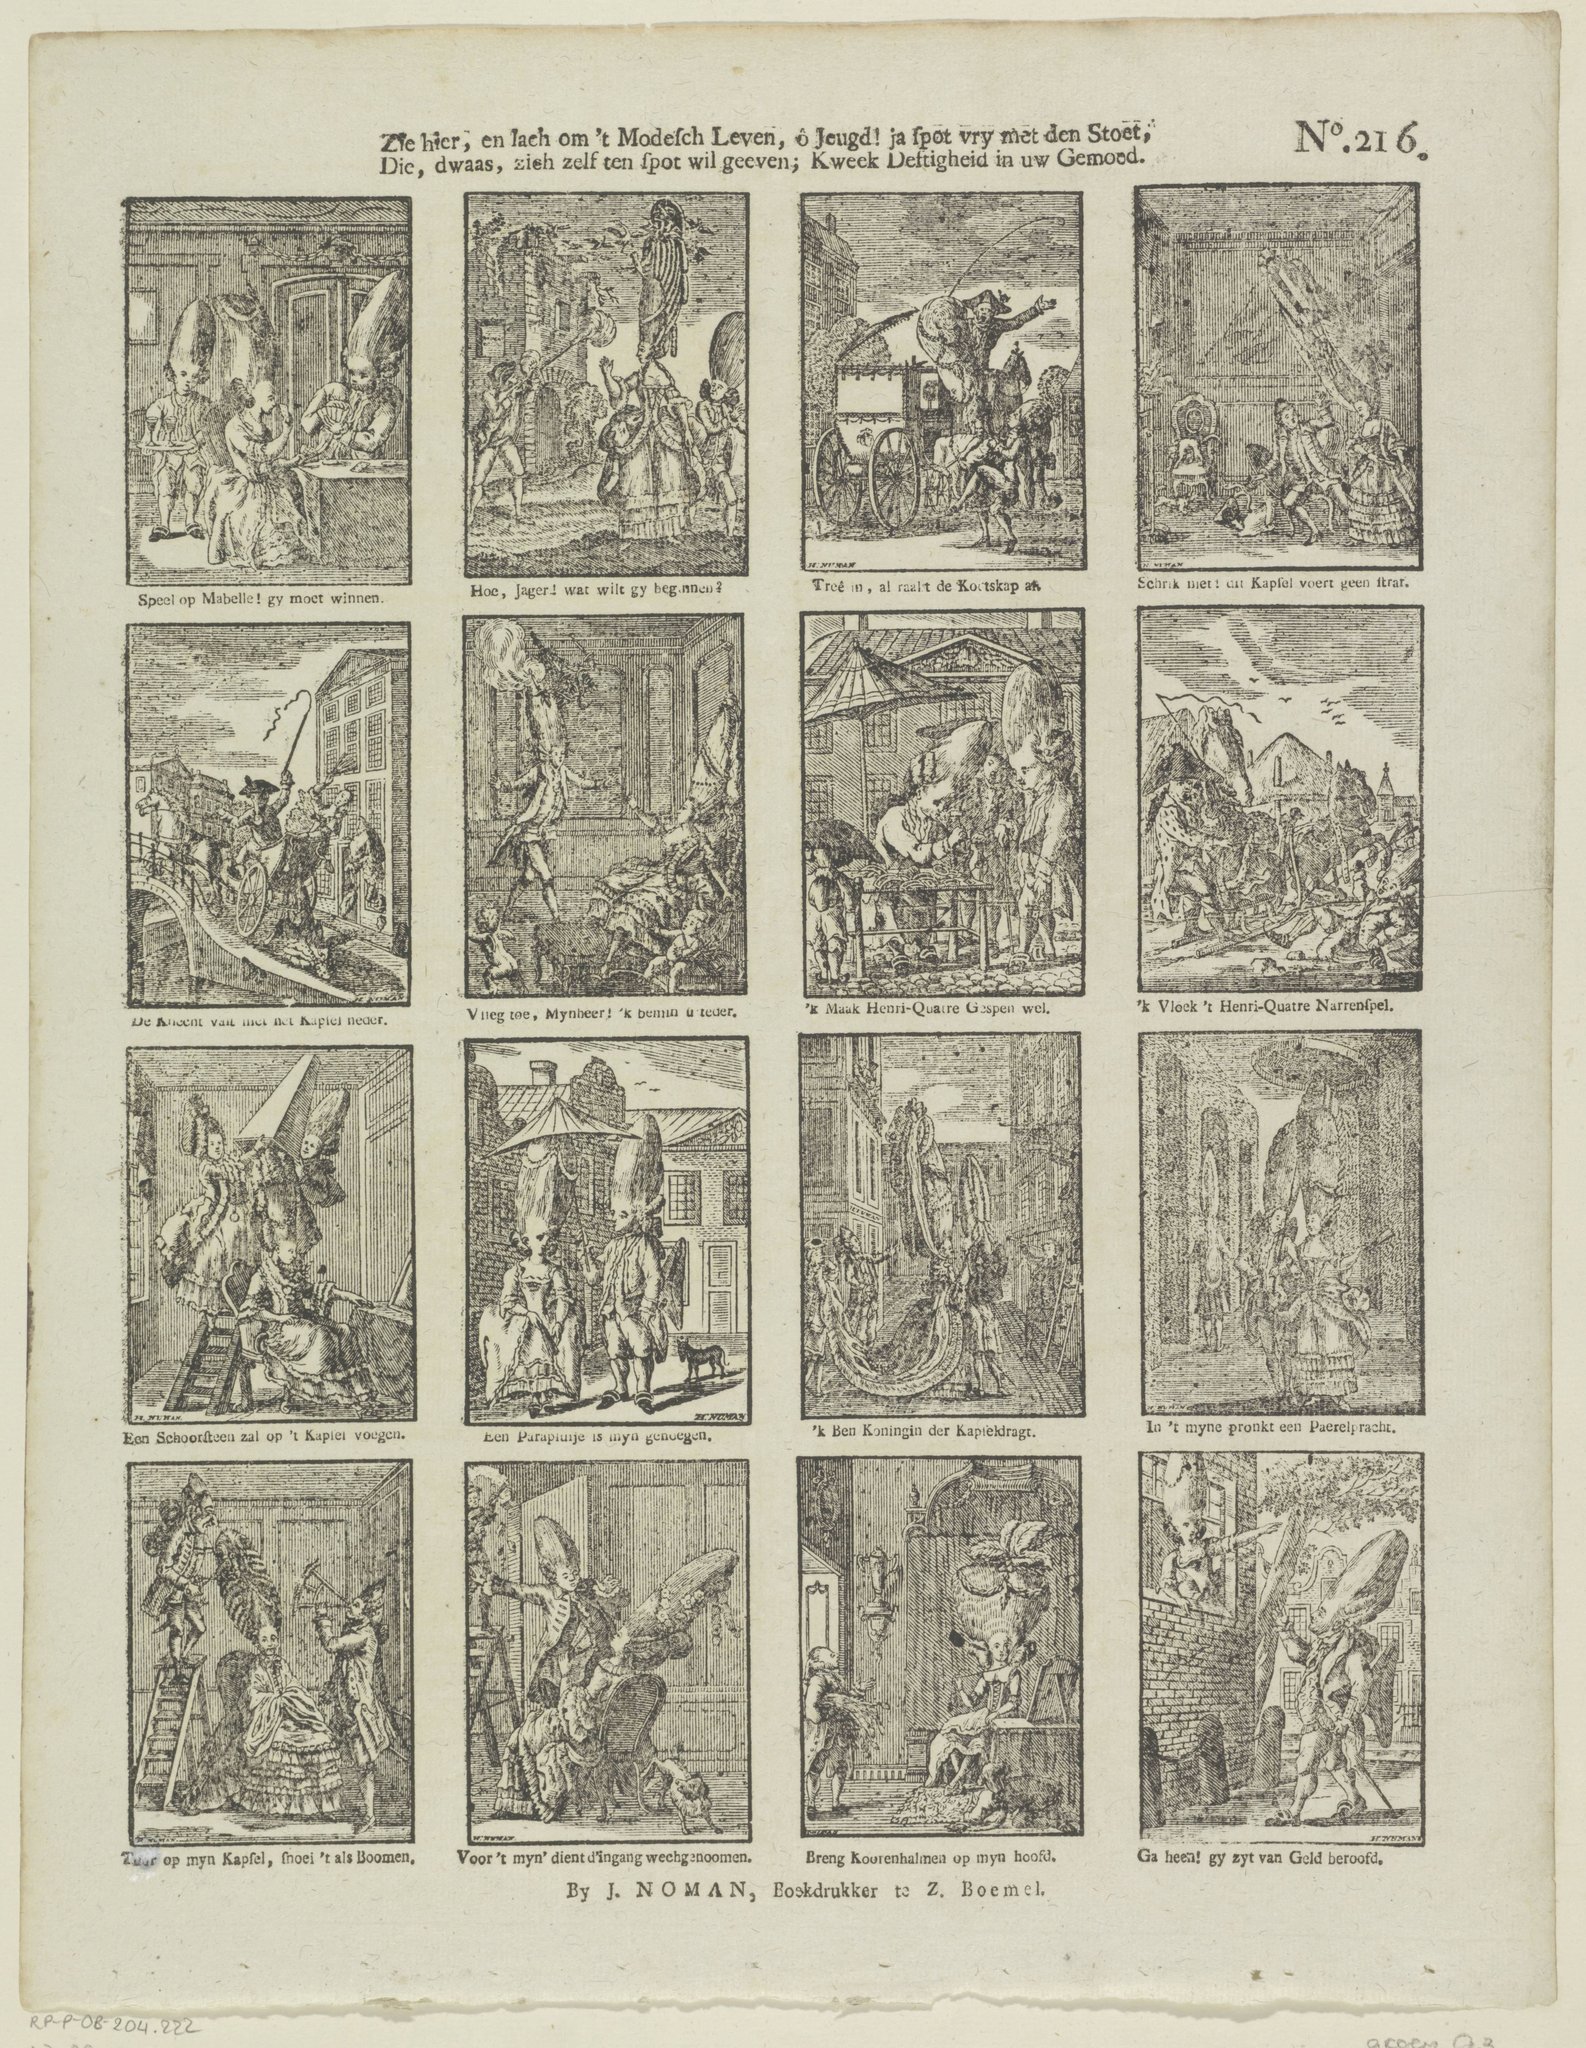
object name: print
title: Zie hier, en lach om 't modesch leven, o jeugd! ja spot vry met den stoet, / Die, dwaas, zich zelf ten spot wil geeven; Kweek deftigheid in uw gemoed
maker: johan noman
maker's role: printer, publisher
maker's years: -1833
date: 1806-1830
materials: paper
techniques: letterpress printing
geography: zaltbommel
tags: styles of hairdress, wig, comedy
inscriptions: collector's mark: Lugt 2760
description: Spotprent op de mode met 16 voorstellingen van mensen met extreem grote pruiken. Onder elke voorstelling een onderschrift. Genummerd rechtsboven: No. 216.